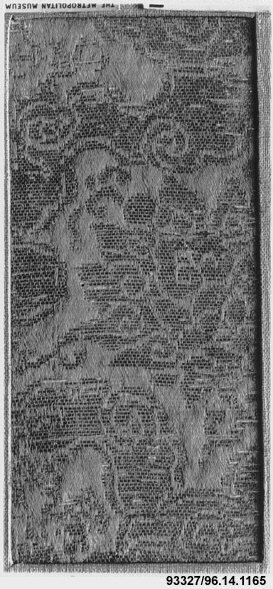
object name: piece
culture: japanese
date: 1701-1900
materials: silk